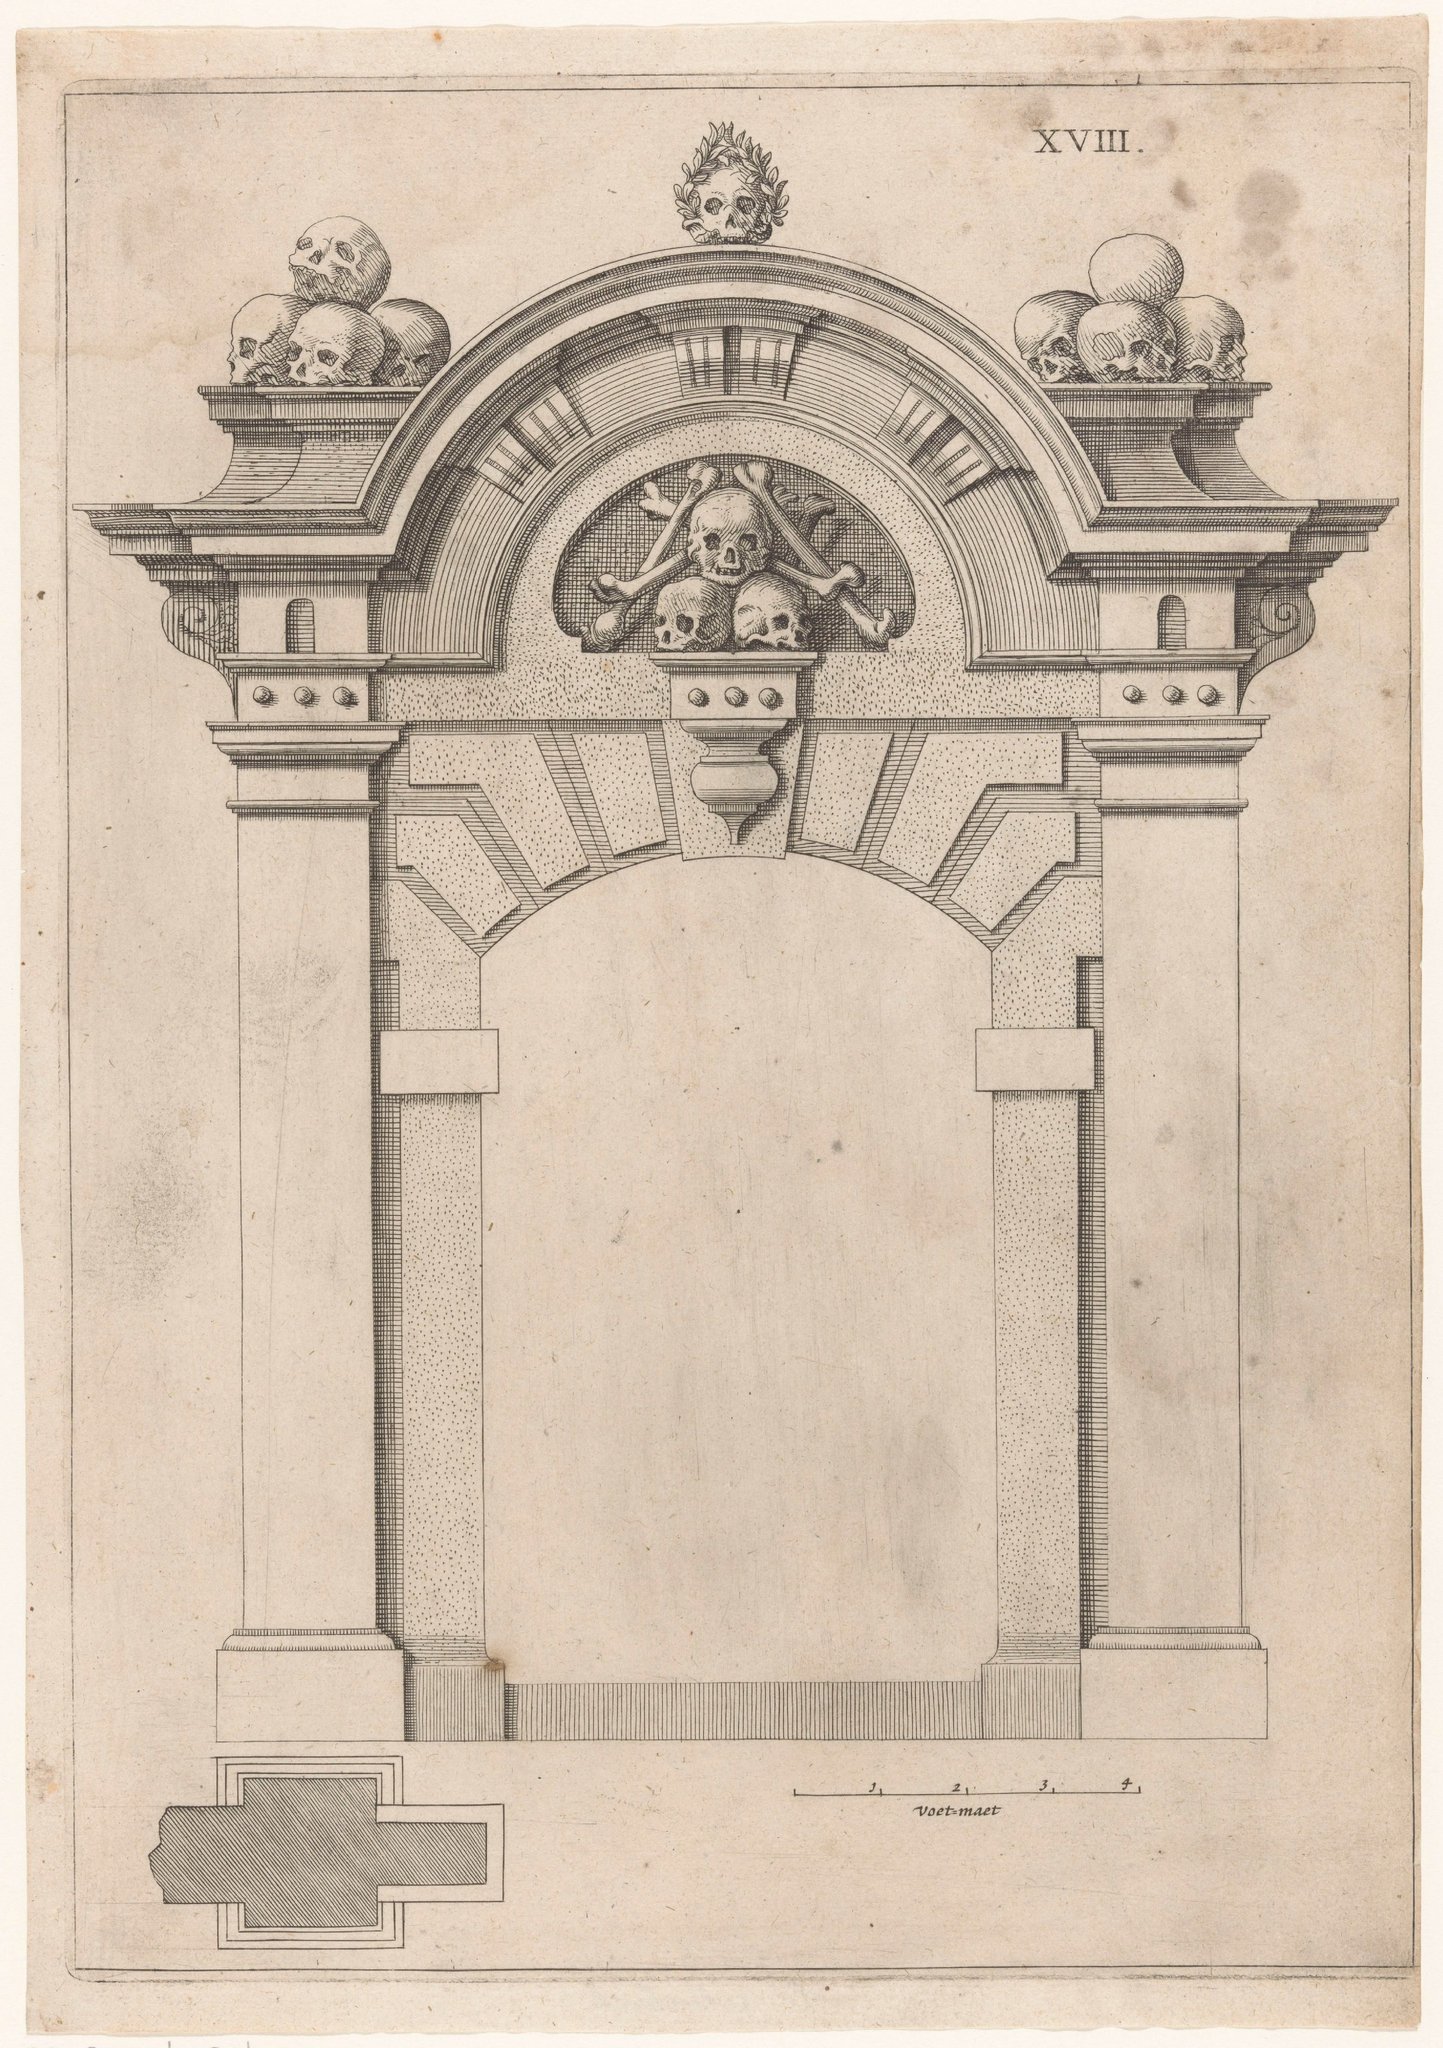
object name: ornament print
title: Poort tot begraafplaats bij de Westerkerk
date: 1631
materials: paper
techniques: engraving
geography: amsterdam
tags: churchyard, cemetery, plan ~ architecture, exterior ~ architectural design or model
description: Prent uit: Keyser, Hendrick de. Architectura moderna ofte bouwinge van onsen tyt (...) alle gedaen by (...) Amsterdam: Danckerts, Cornelis, 1631.